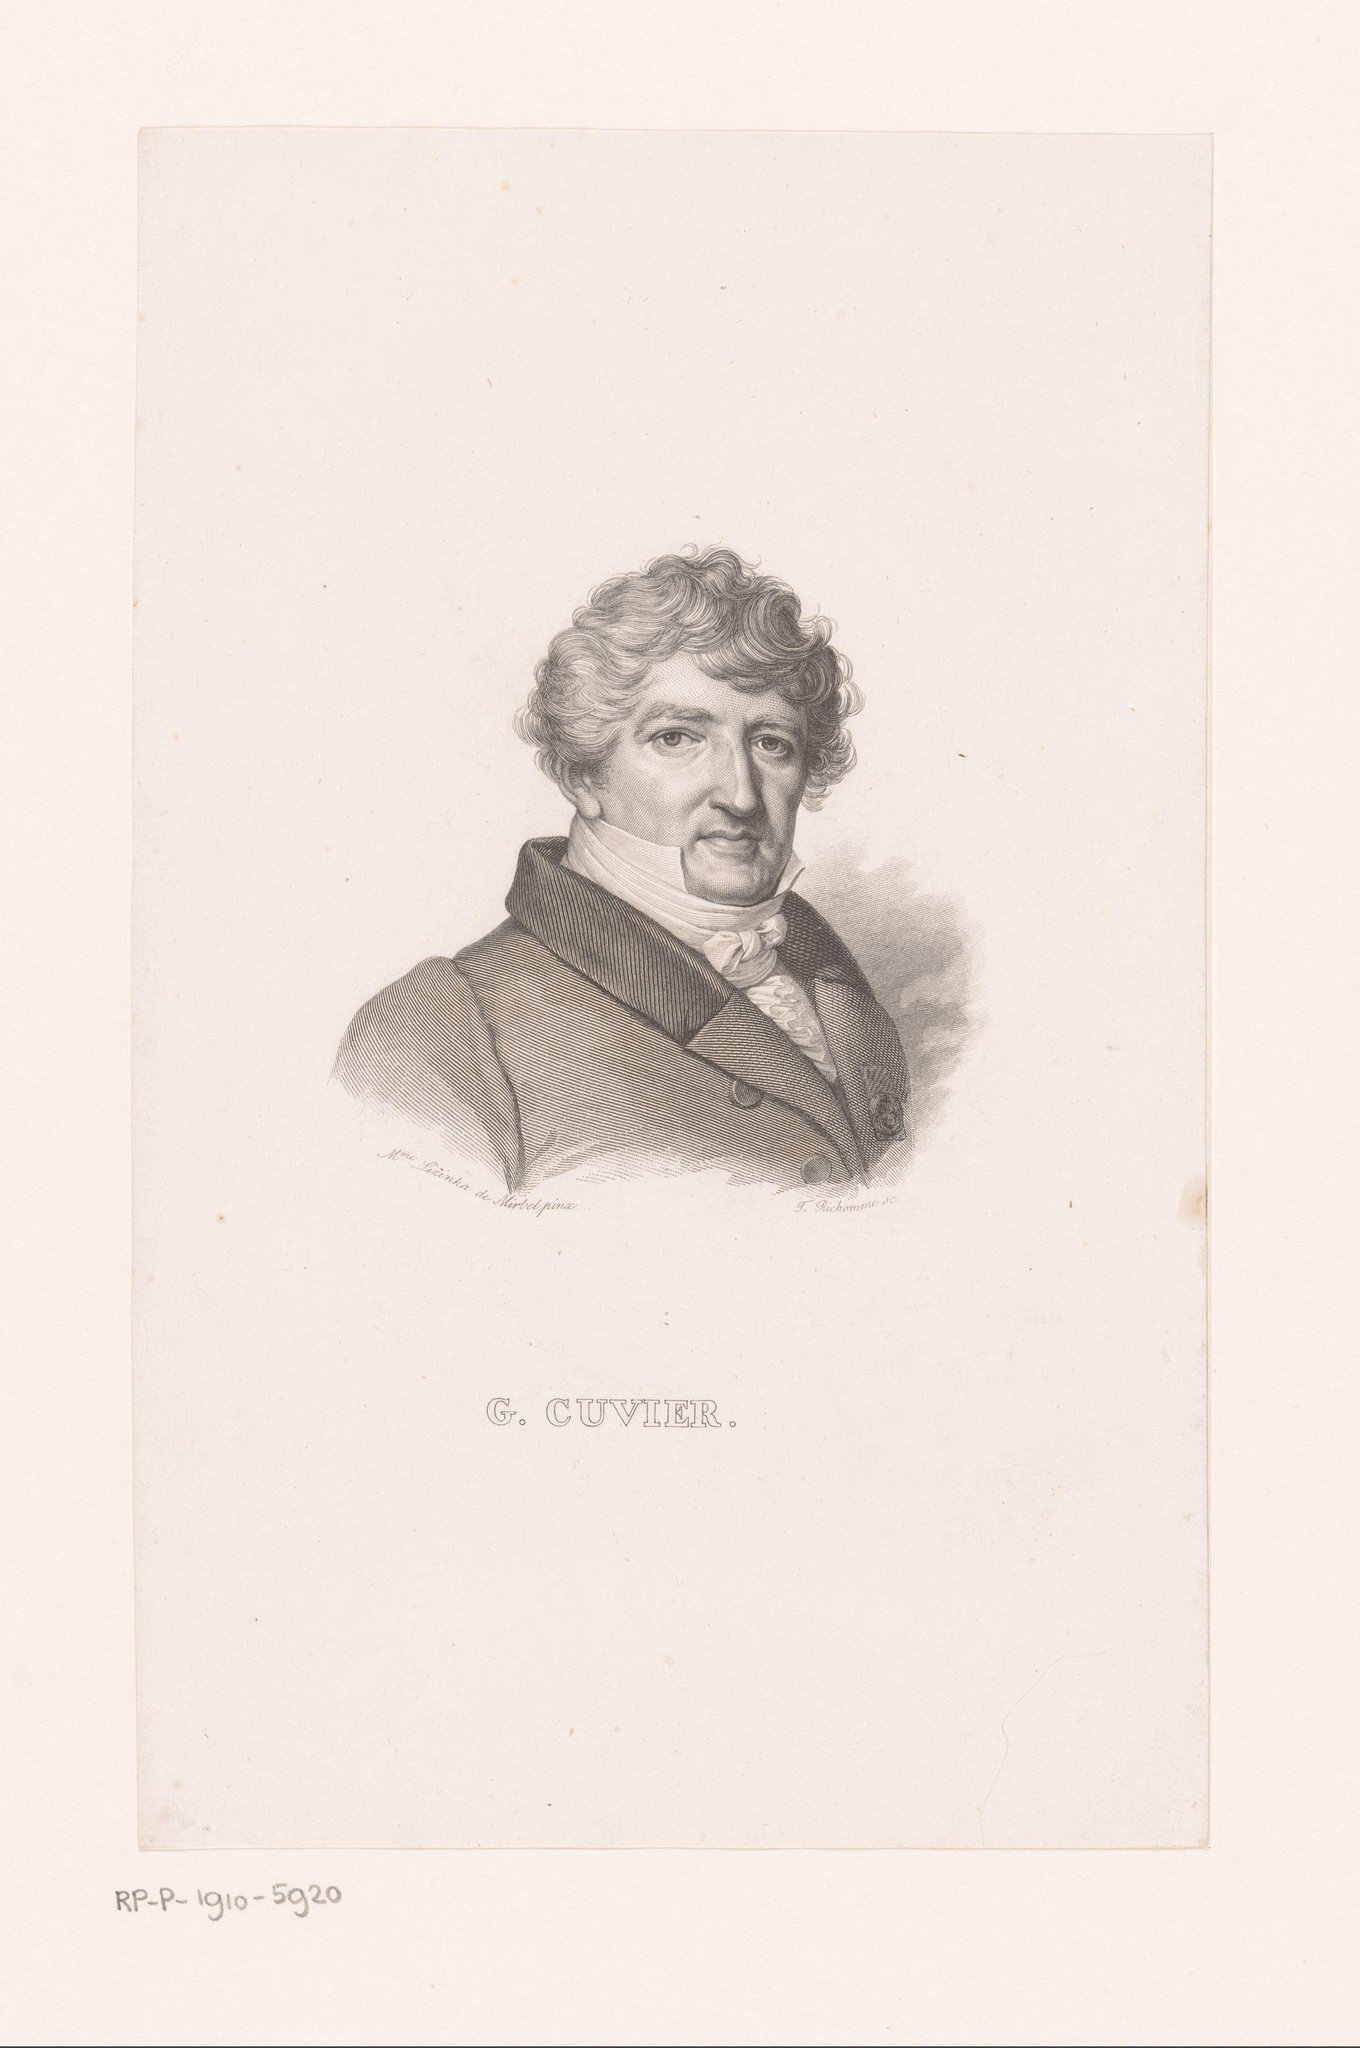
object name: print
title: Portret van Georges Cuvier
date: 1795-1849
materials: paper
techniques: engraving, etching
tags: paris, historical persons, nobility and patriciate; chivalry, knighthood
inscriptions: collector's mark: Lugt 2228